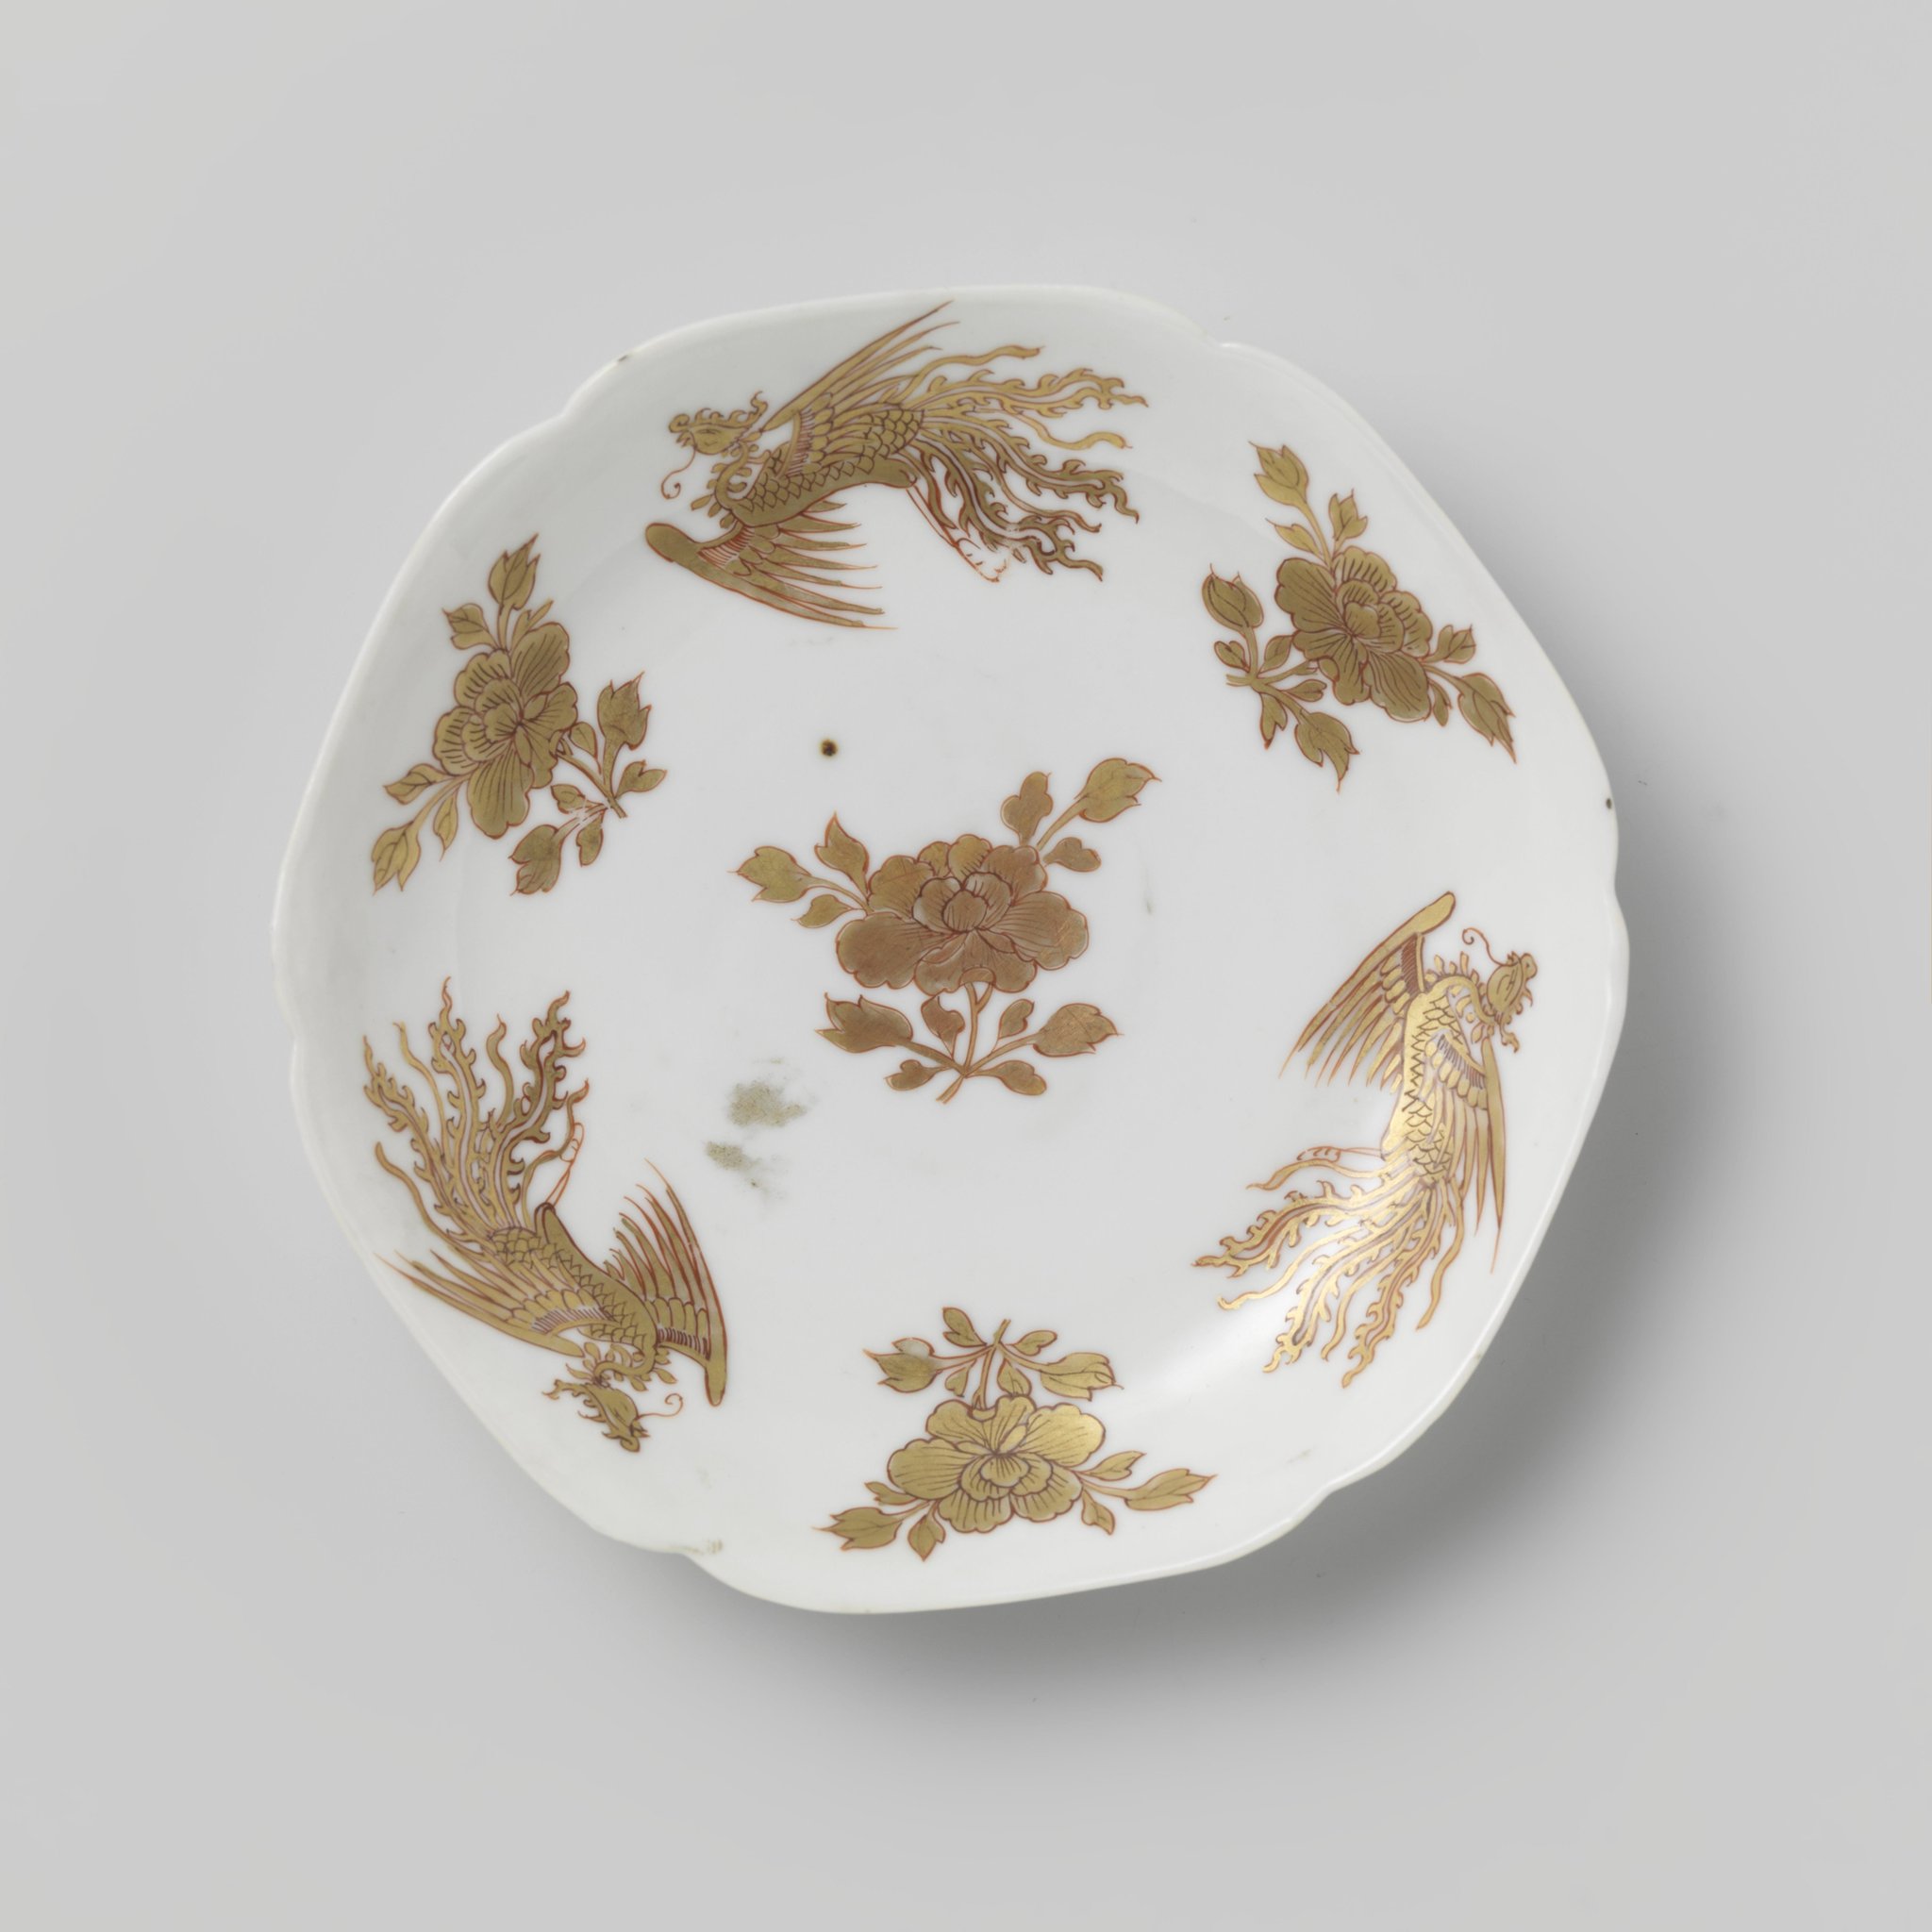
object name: kop en schotel, kop en schotel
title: Saucer with flower sprays and feng huangs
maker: Anonymous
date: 1700-1724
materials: glaze, paint, porcelain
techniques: firing, gilding, turning, vitrification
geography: china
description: Schotel van porselein met een zeslobbige rand, beschilderd op het glazuur in rood en goud. Op het plat van de schotel drie feng huangs en drie bloemtakken om een bloemtak in het centrum; op de achterzijde drie bloemen. Melk en bloed.